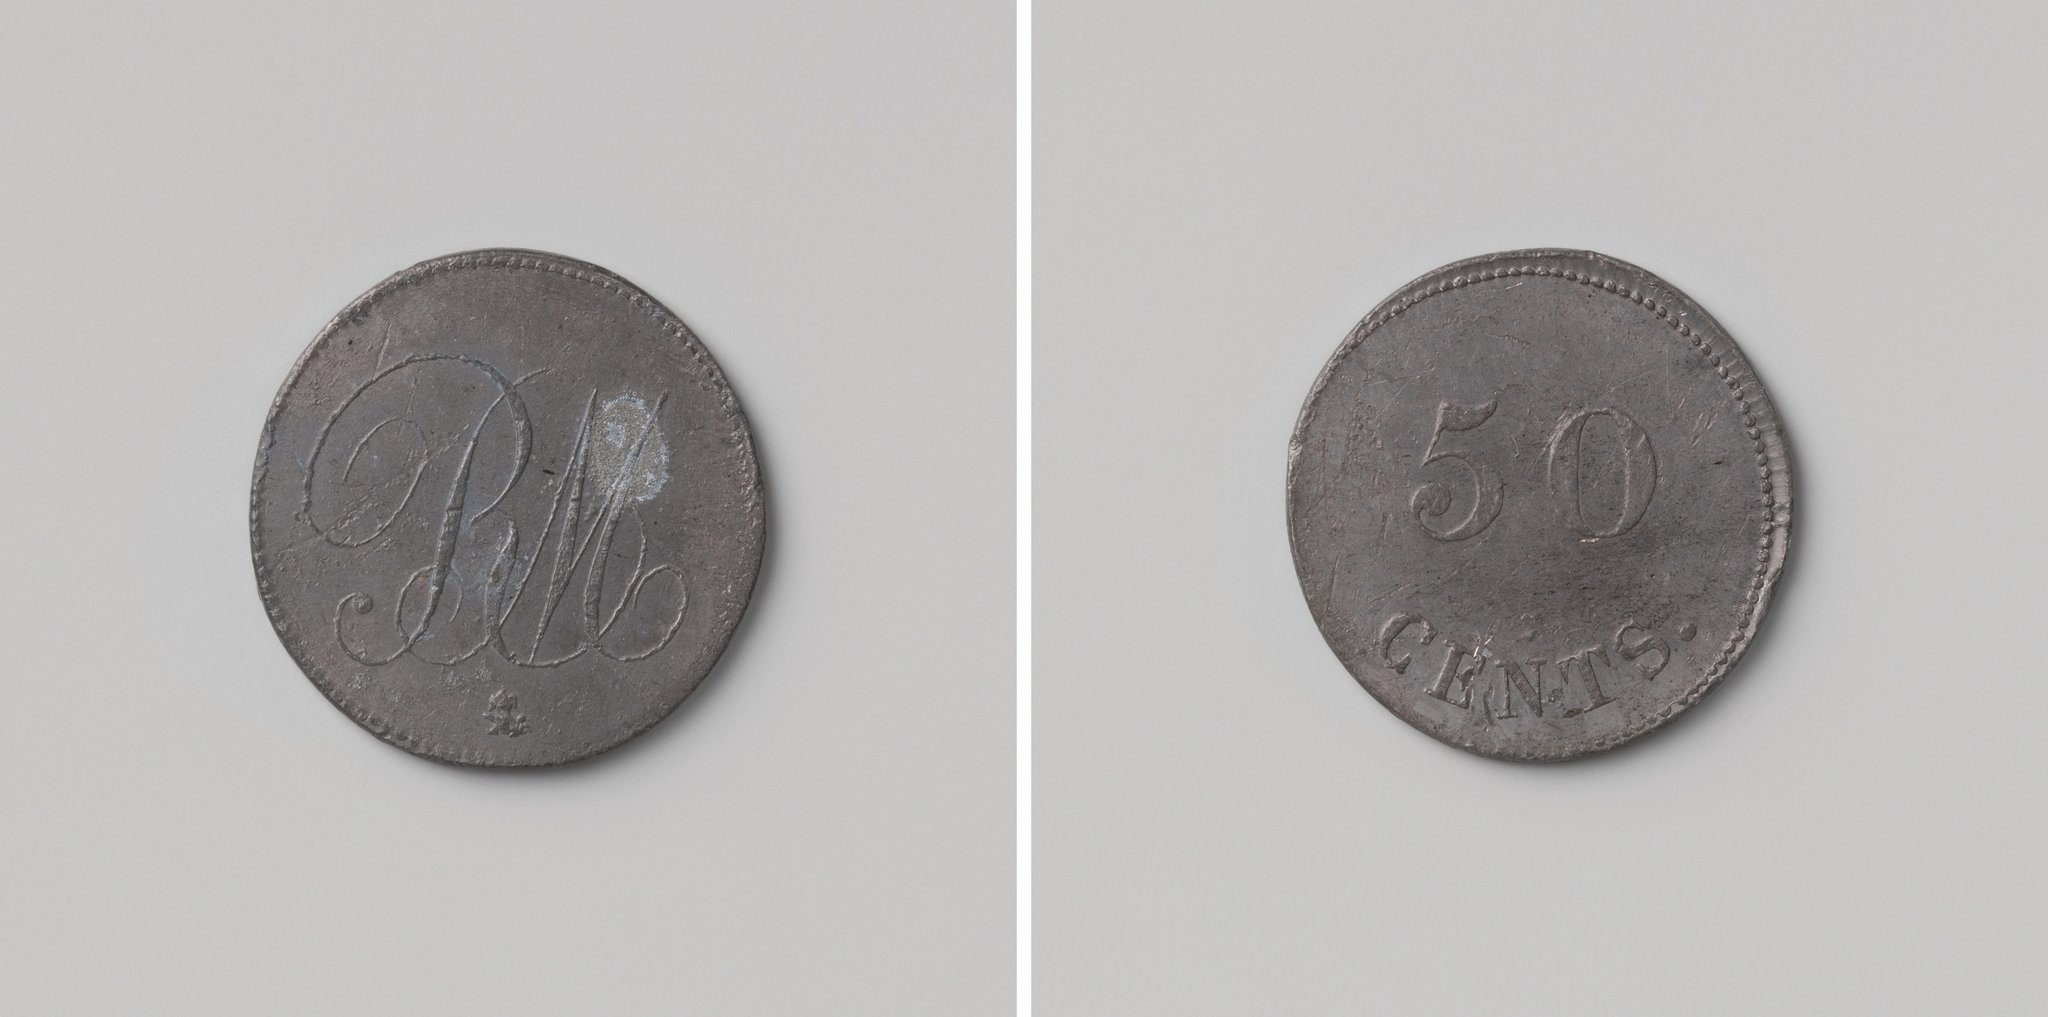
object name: monetary token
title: Huismunt van de kolonies Rijkevorsel en Merksplas van 50 cent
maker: Anonymous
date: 1823-1839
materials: zinc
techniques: striking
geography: brussels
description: Zinken munt. Voorzijde: monogram van letters R en M boven merktekentje. Keerzijde: waardeaanduiding